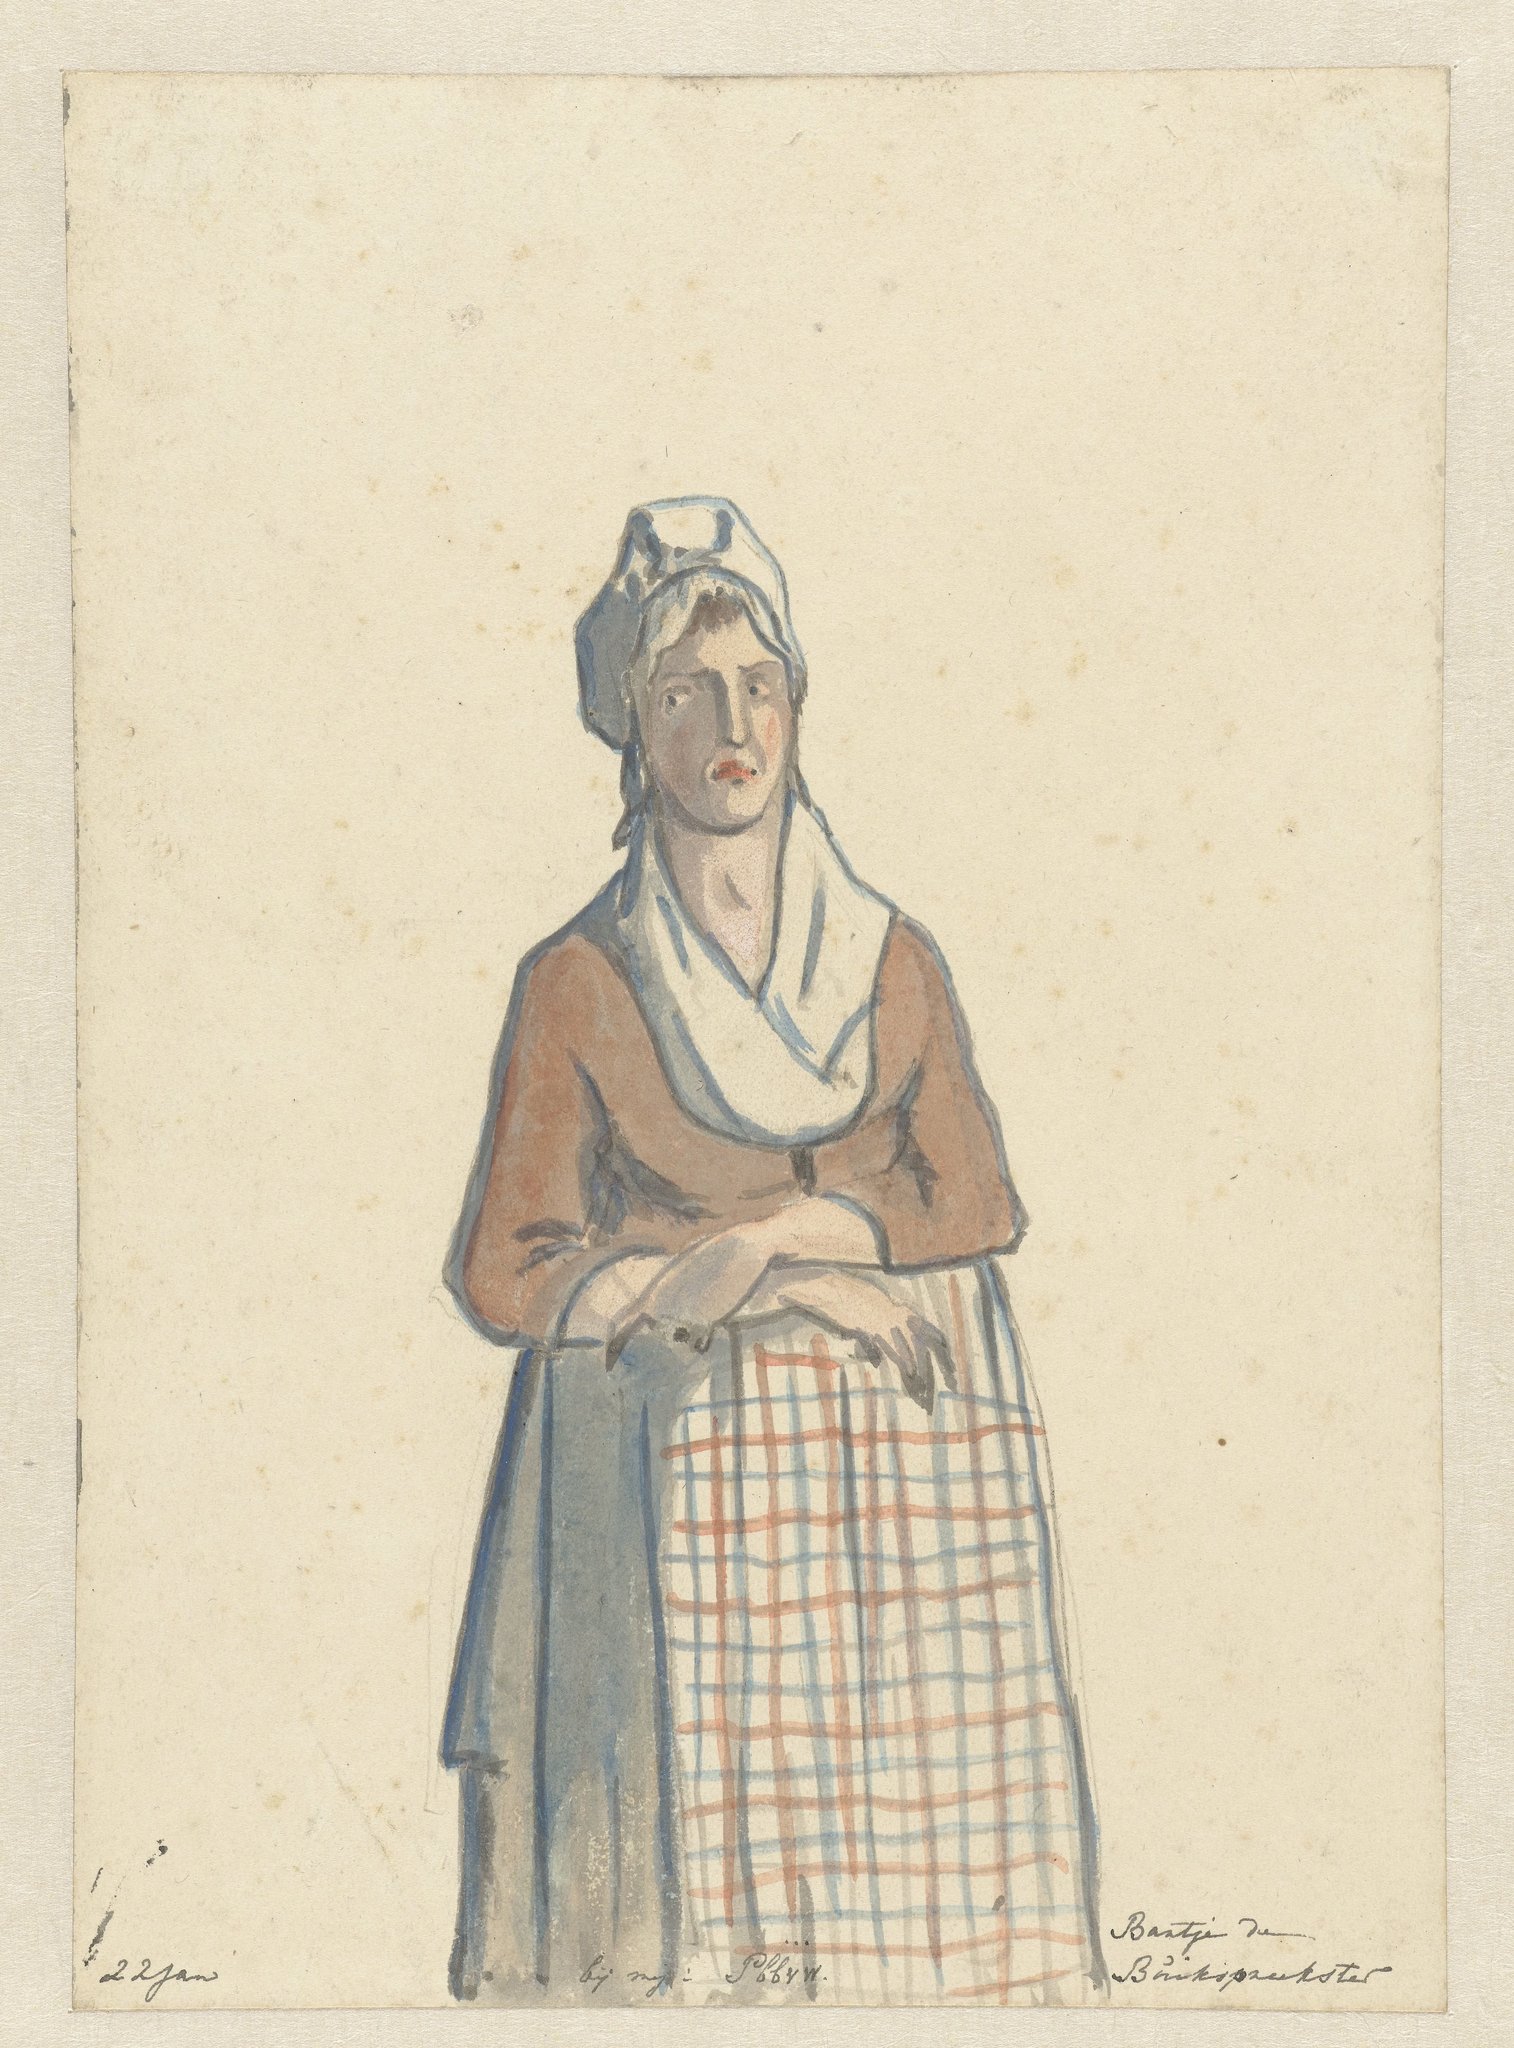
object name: drawing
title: Bartje de Buikspreekster (dagboek, 22 januari)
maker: christiaan andriessen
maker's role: draughtsman, print maker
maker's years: 1775-1846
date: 1805-1808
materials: paper, pencil, watercolor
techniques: brush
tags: historical persons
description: Blad uit het getekende dagboek dat Christiaan Andriessen bijhield van 1805 tot en met 1808